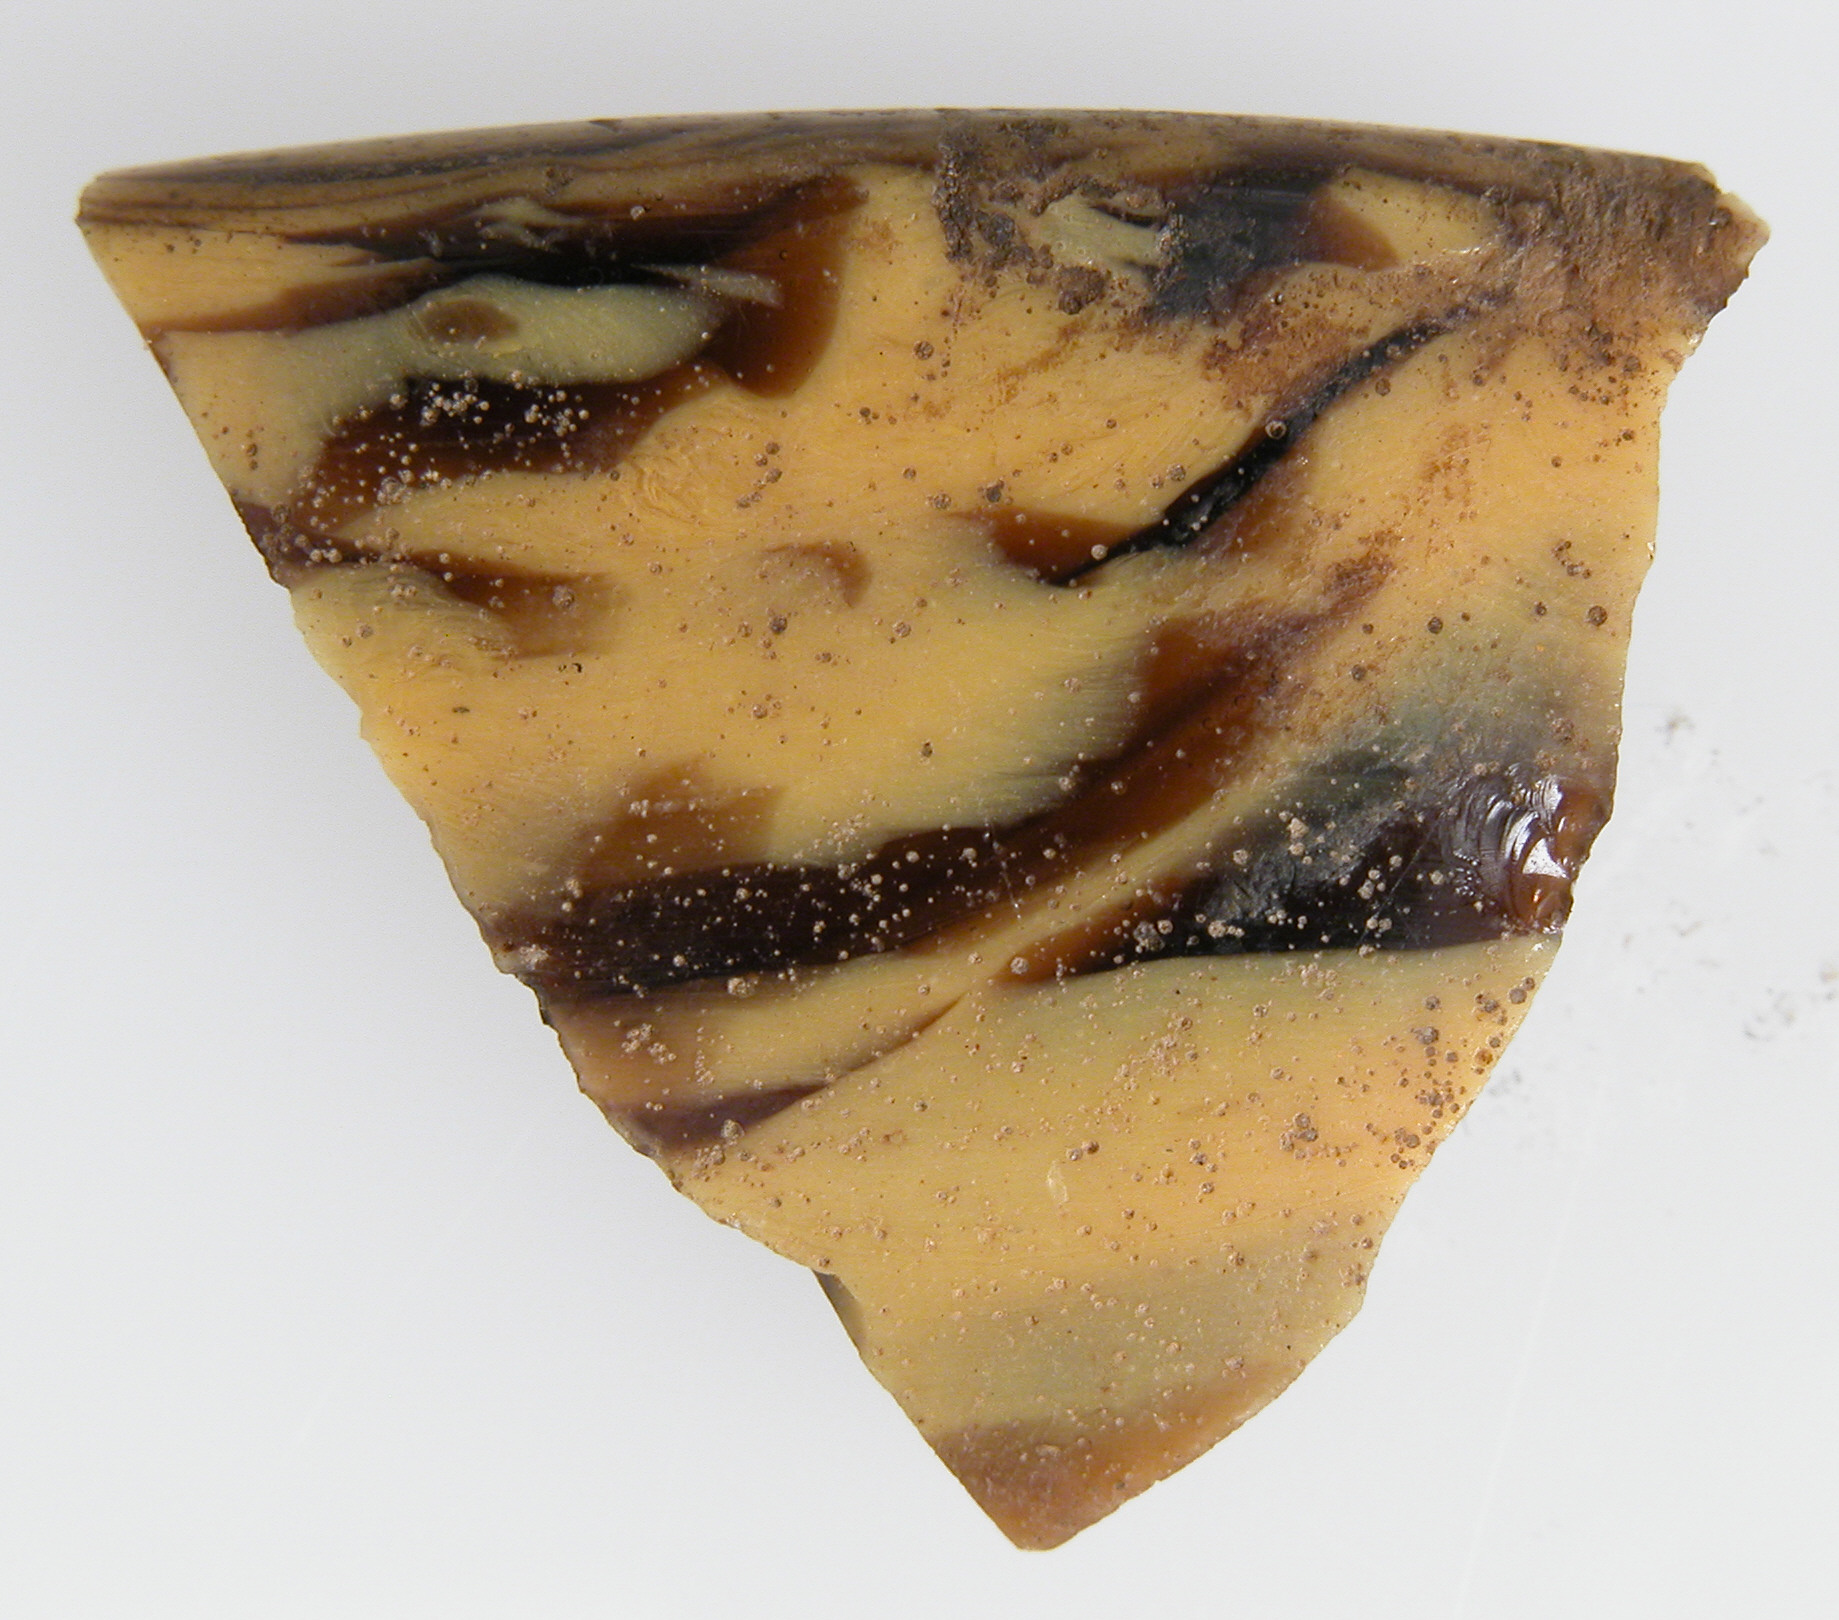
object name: fragment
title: Glass Fragment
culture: coptic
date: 301-433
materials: glass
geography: egypt